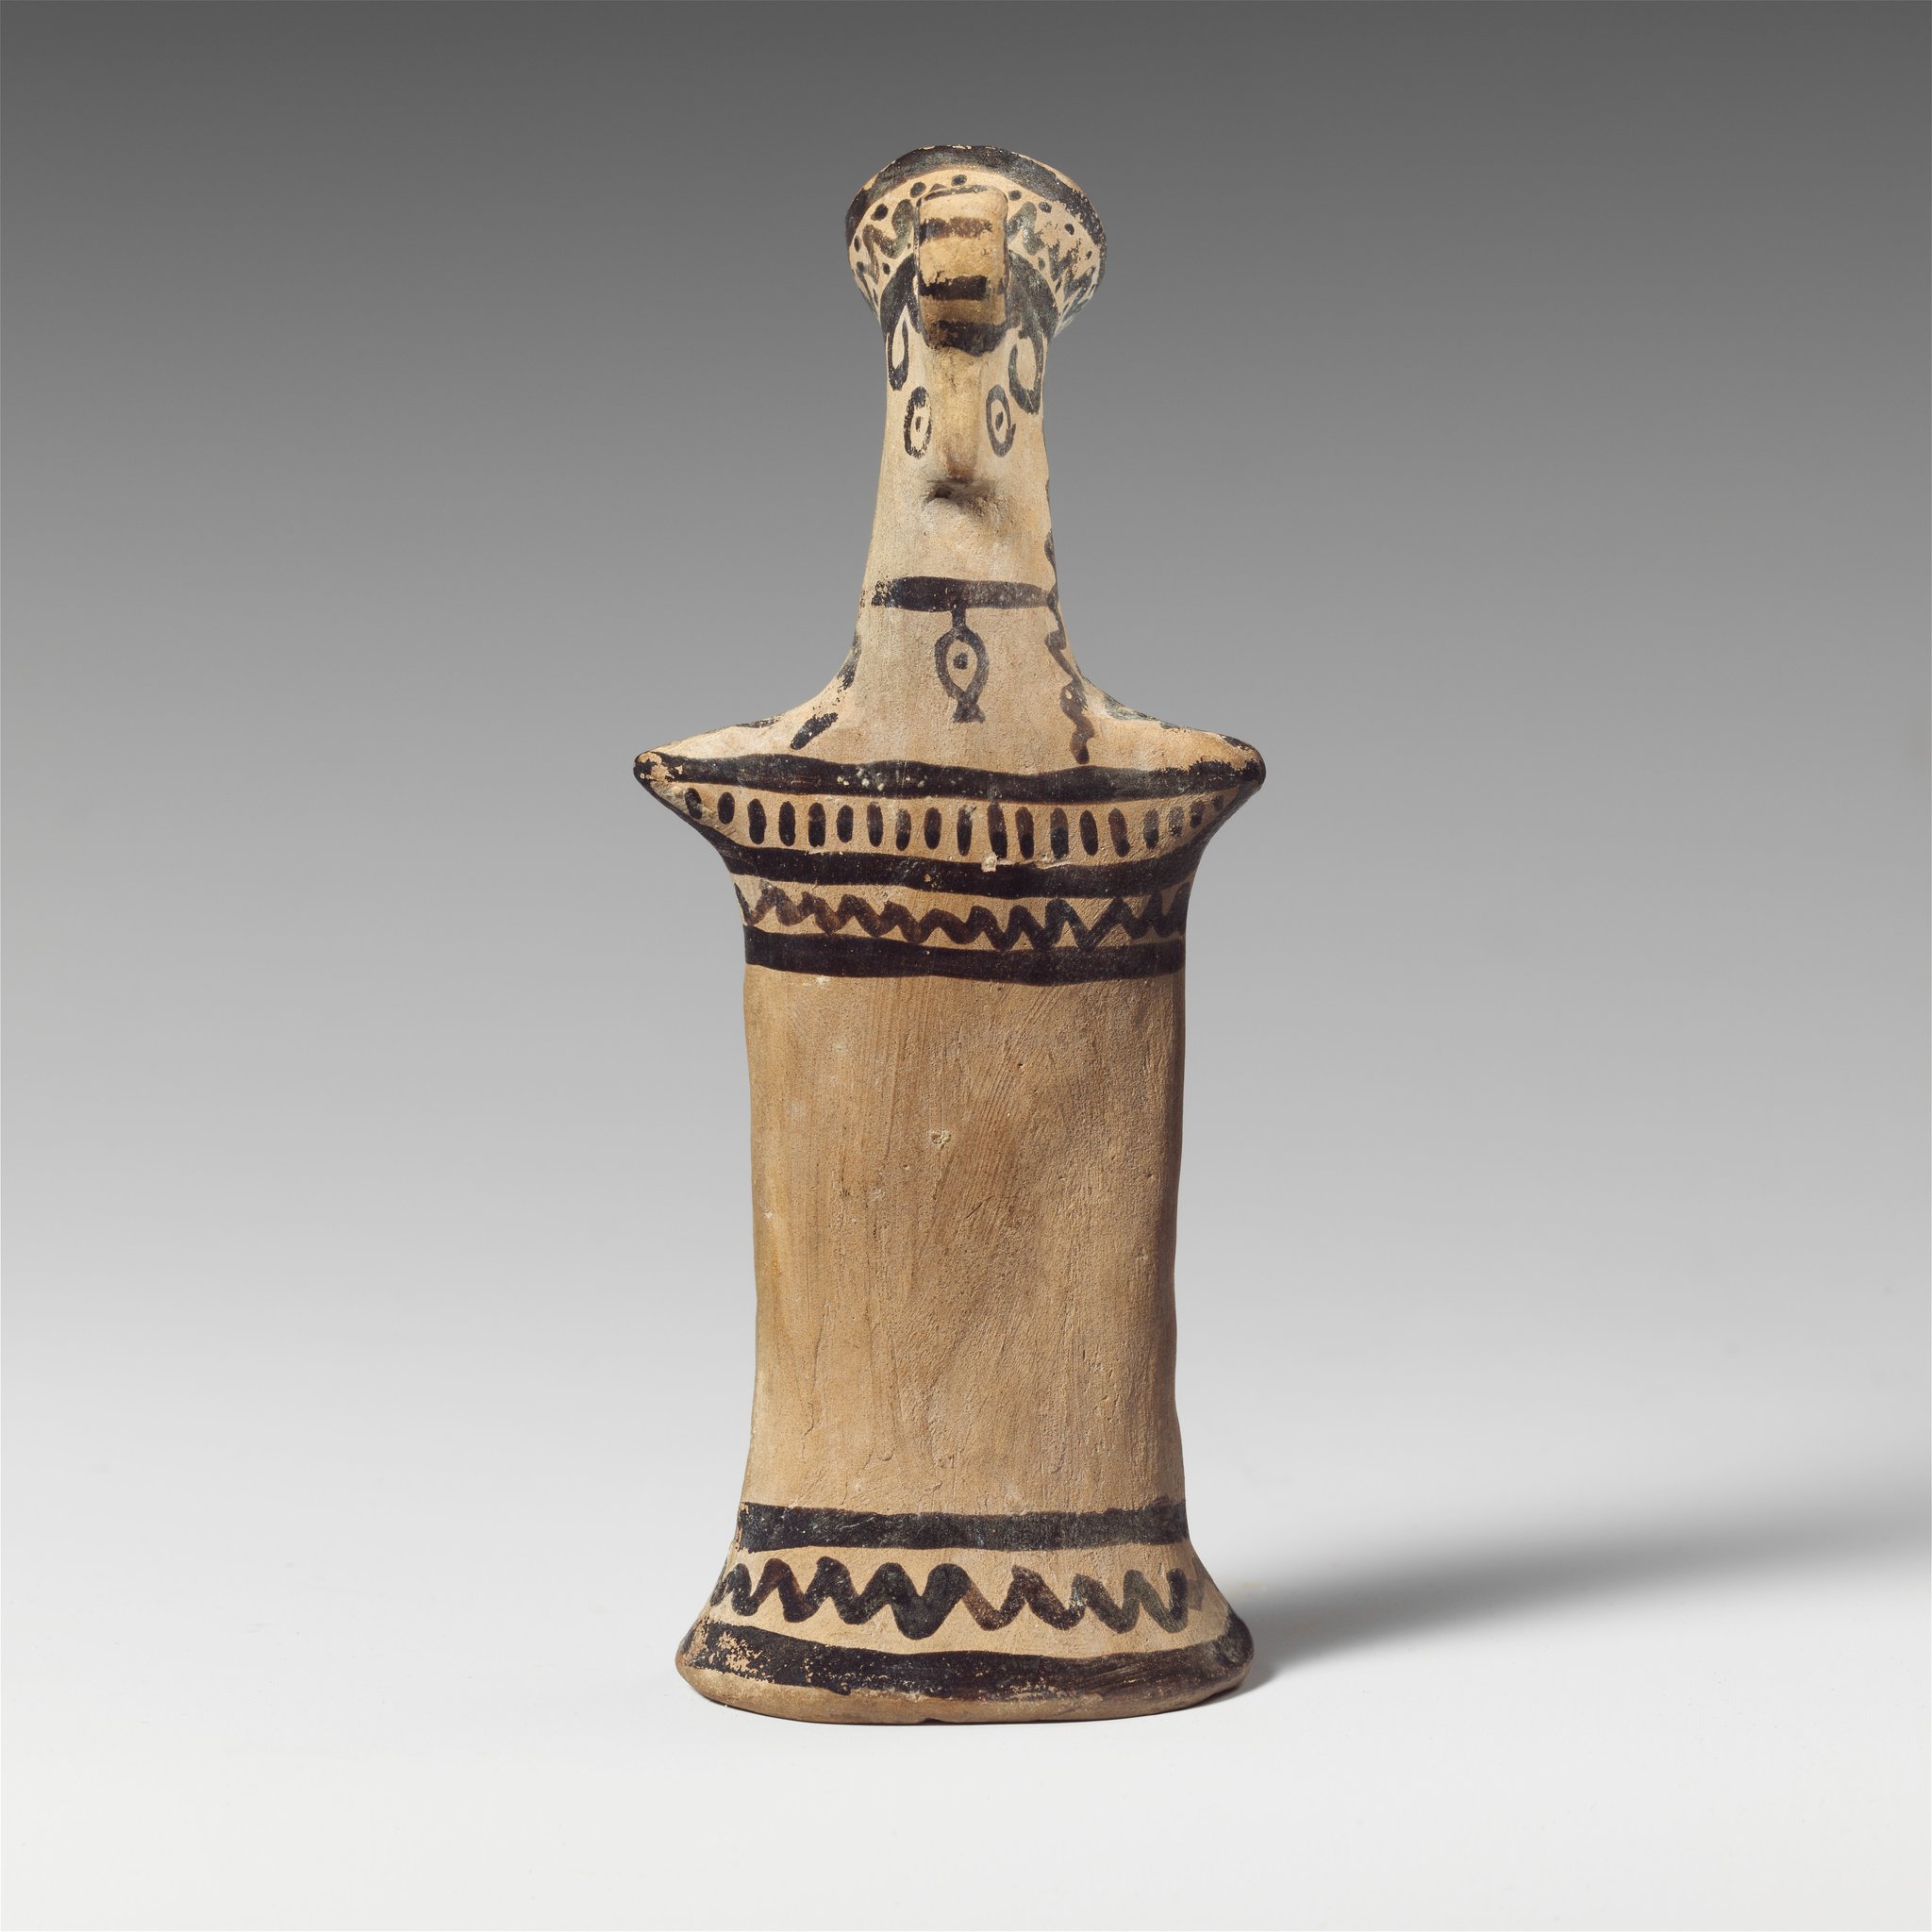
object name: statuette of a seated goddess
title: Terracotta statuette of a goddess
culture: greek, boeotian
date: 600-501 BCE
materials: terracotta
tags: goddess